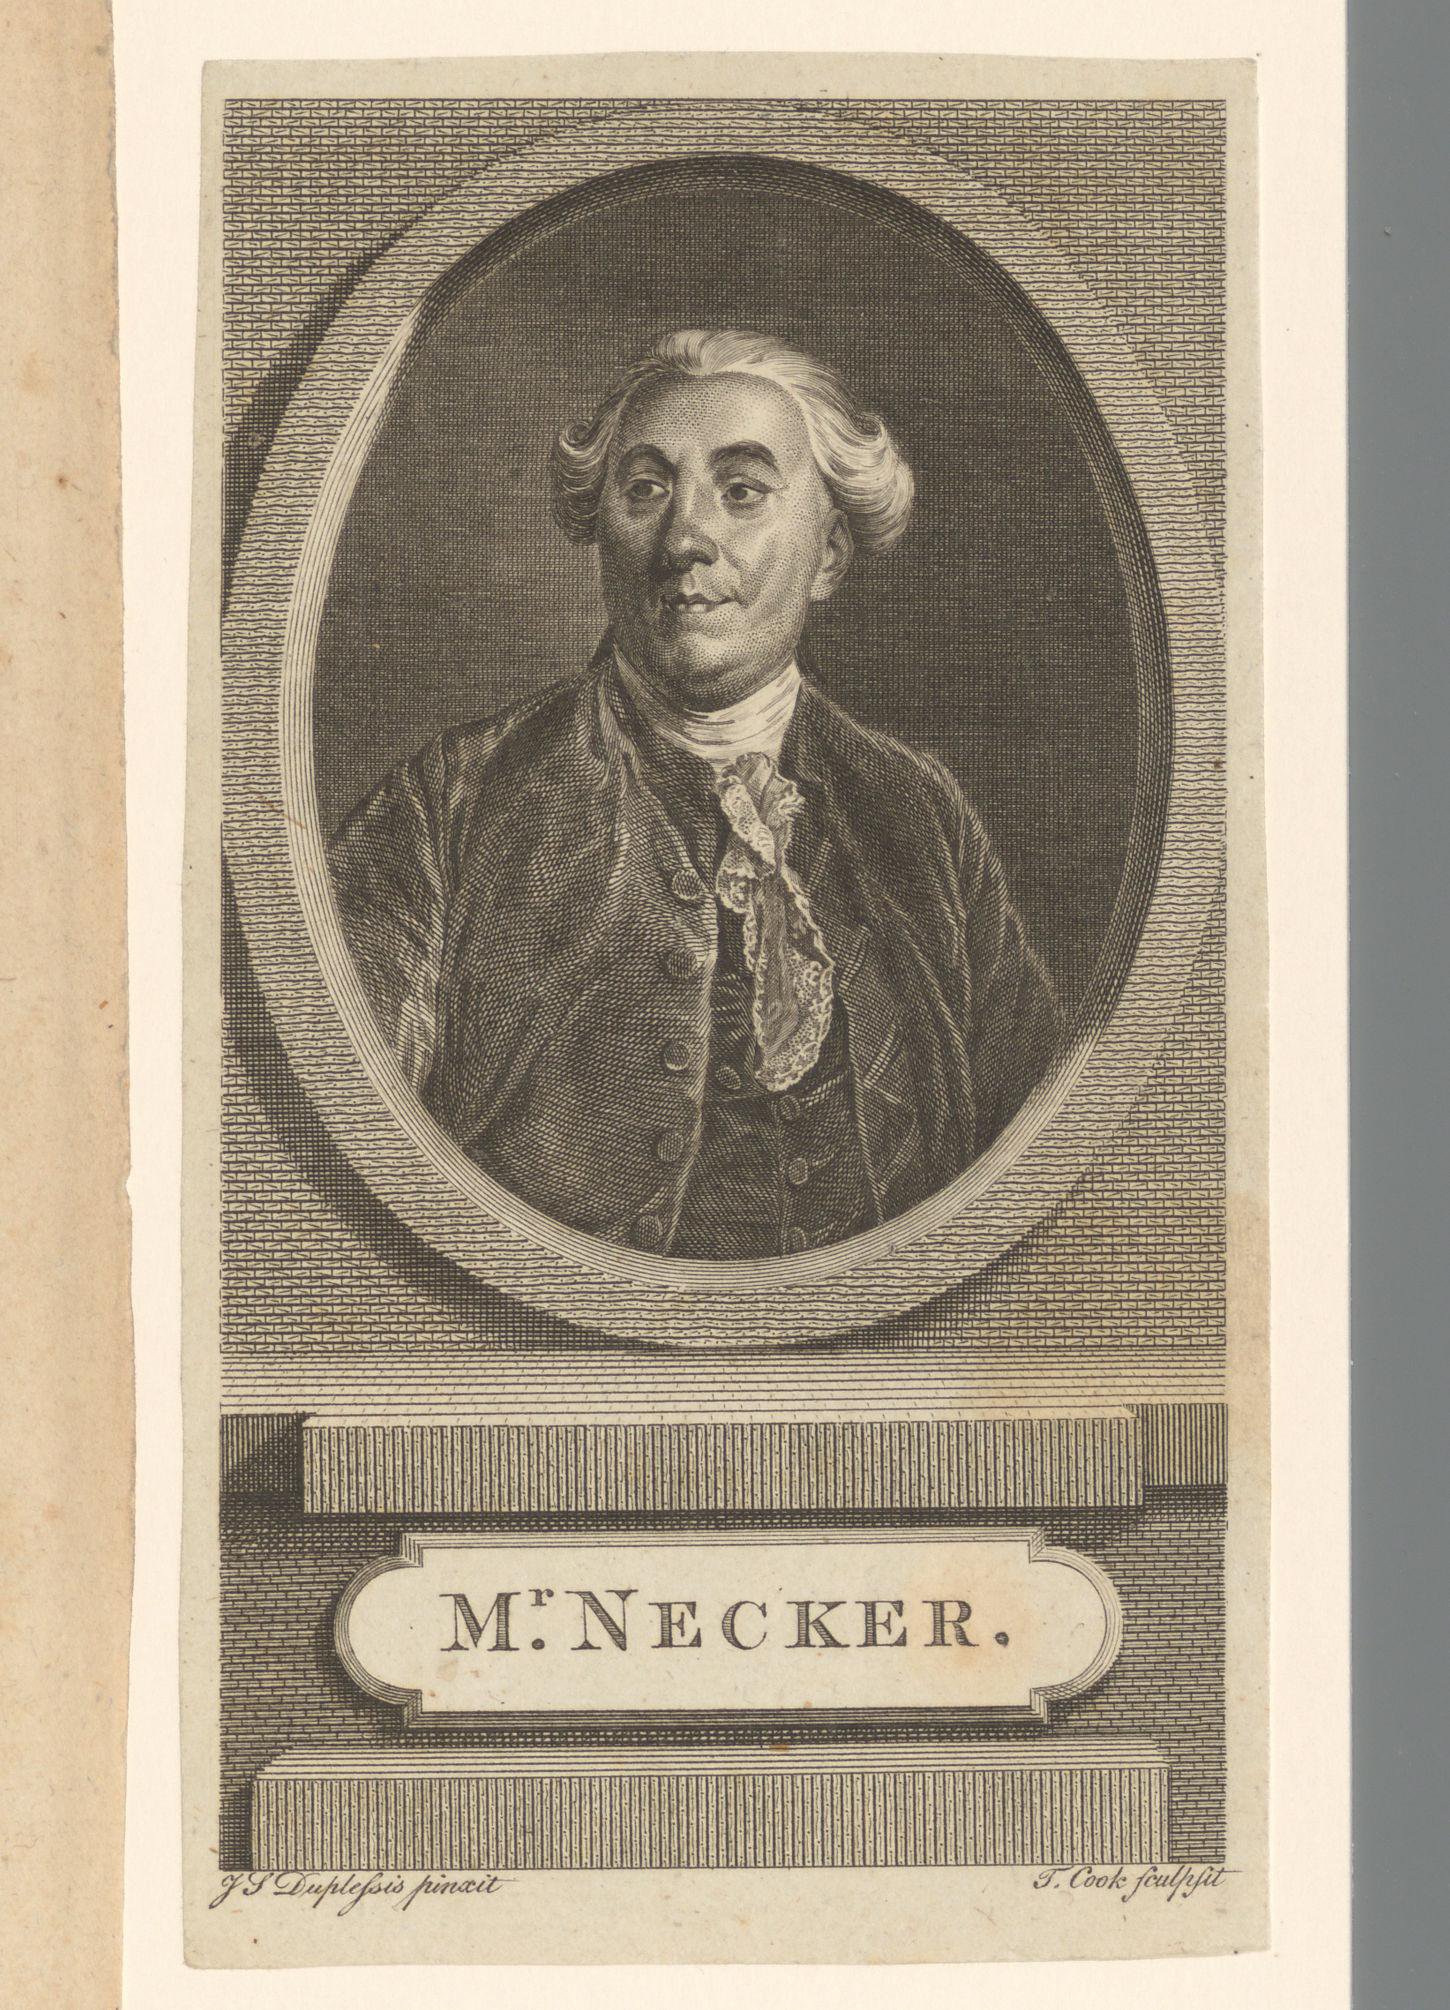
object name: print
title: Portret van Jacques Necker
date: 1754-1785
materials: paper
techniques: engraving, etching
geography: london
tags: historical persons, politician, e.g. party leader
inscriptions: collector's mark: Lugt 2228